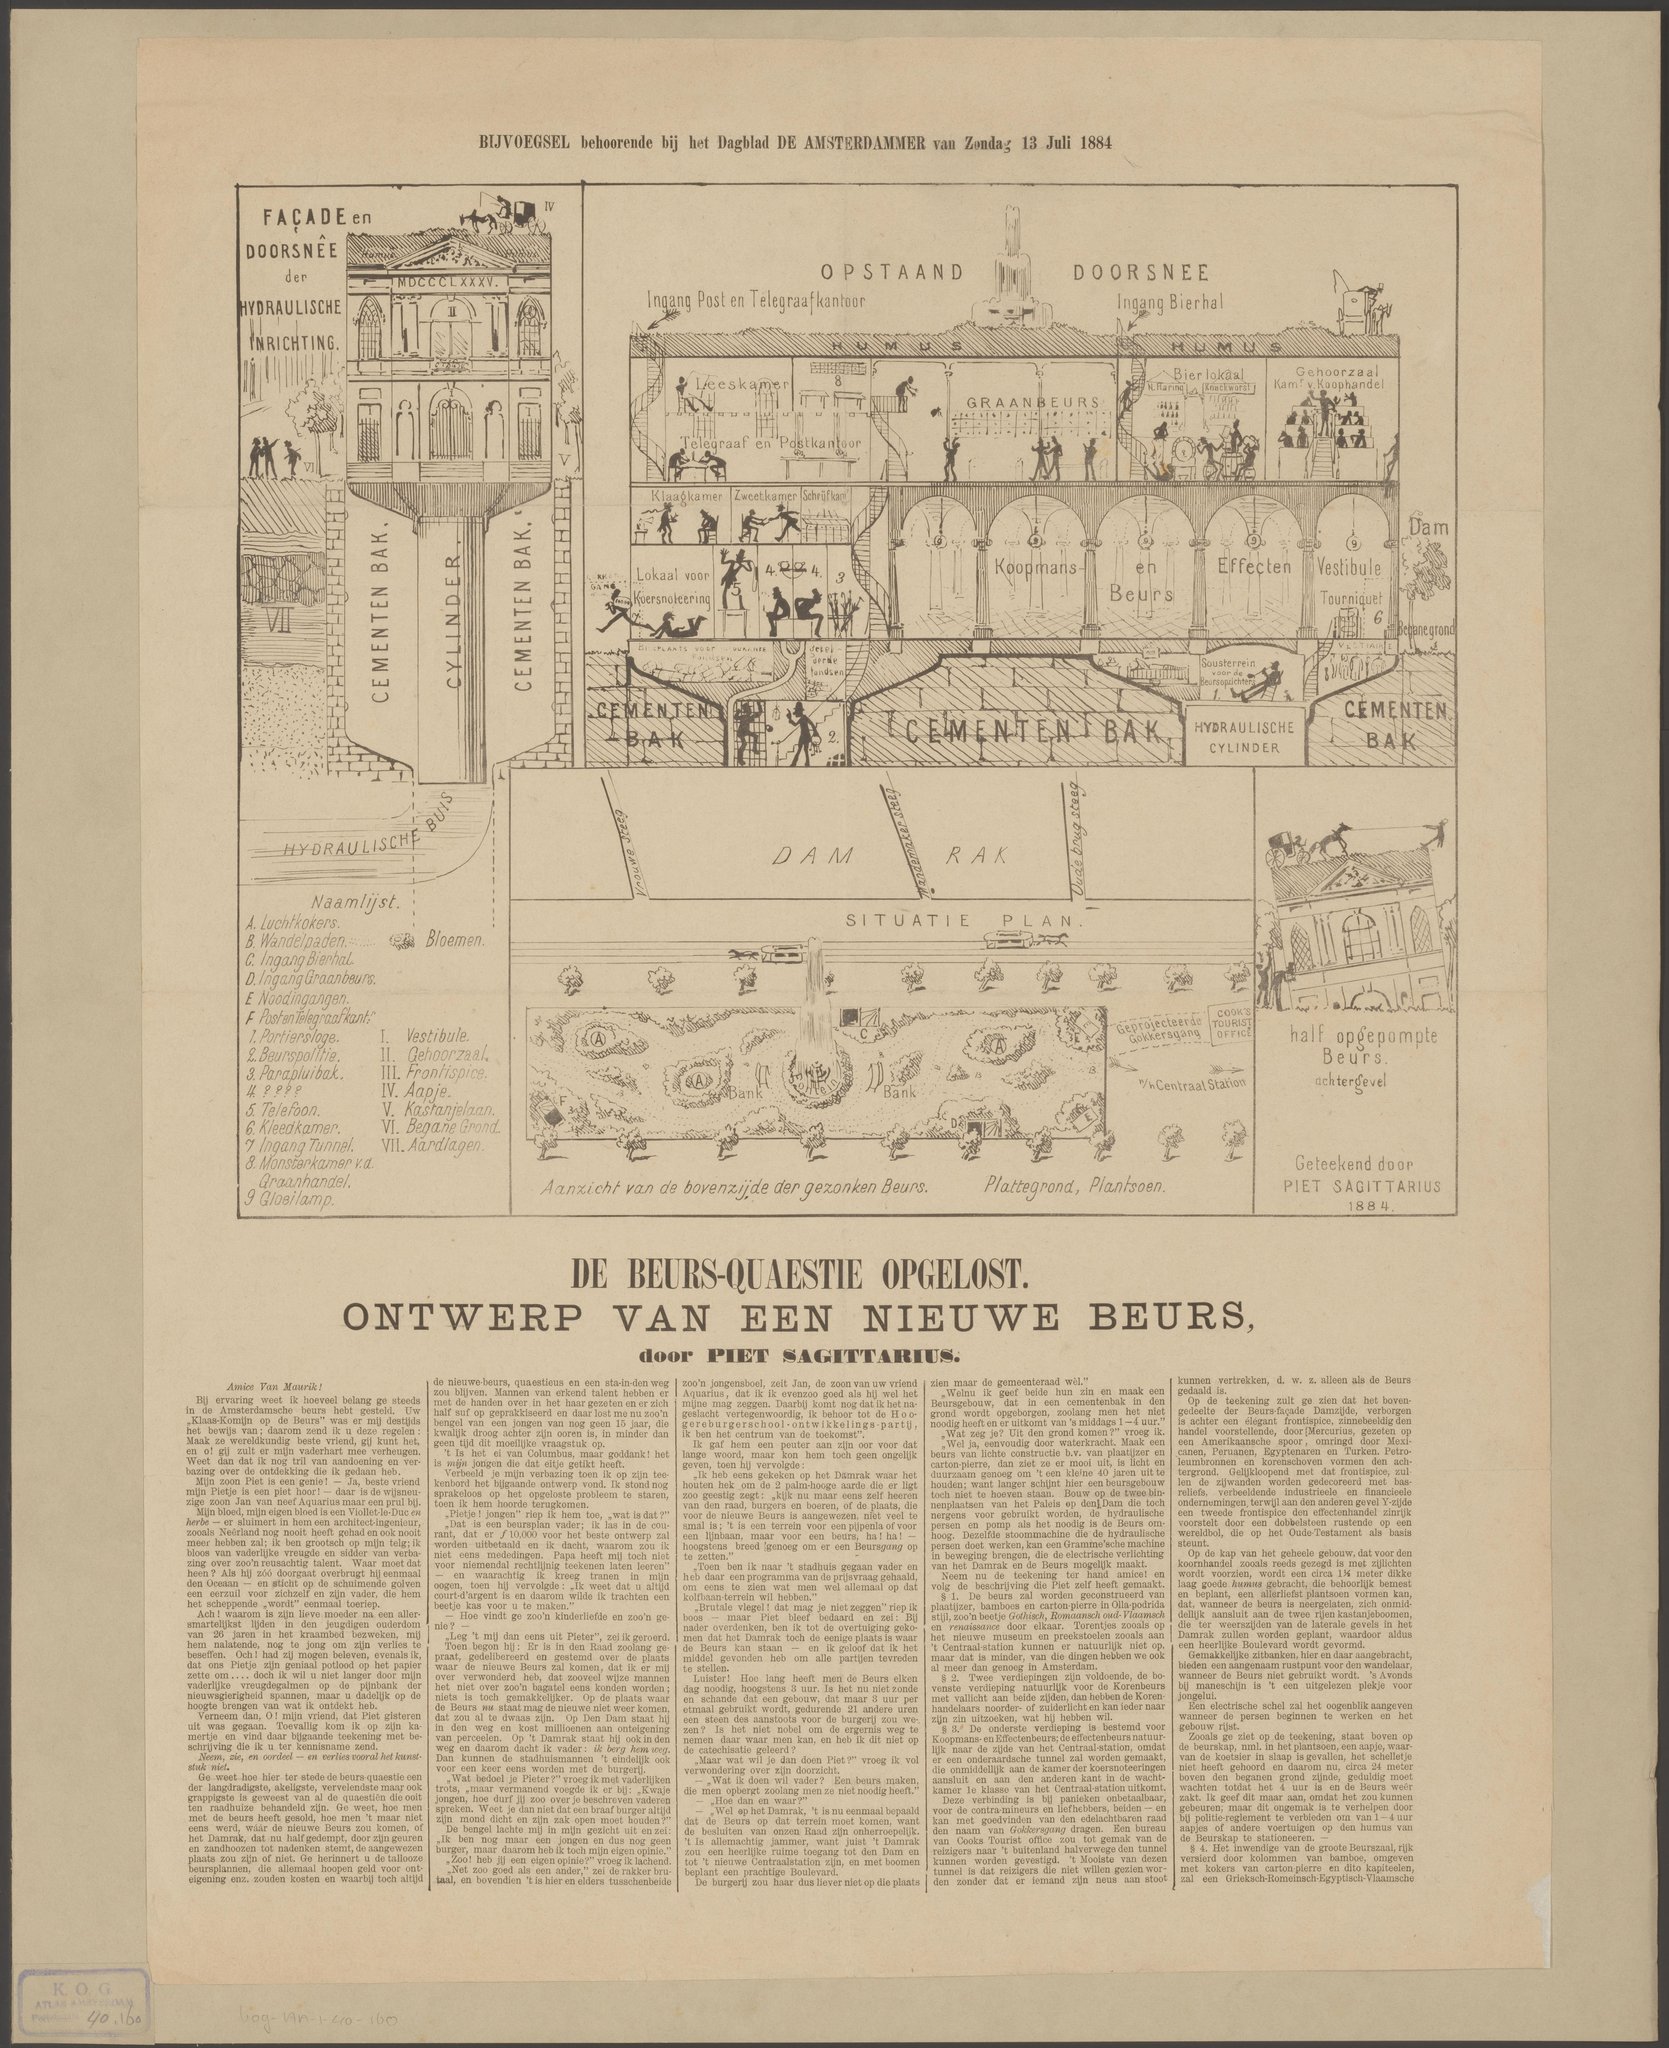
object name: print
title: Oplossing van de beurskwestie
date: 1884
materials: paper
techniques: letterpress printing, lithograph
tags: stock exchange, stock-market, amsterdam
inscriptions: collector's mark: Lugt 1641b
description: Oplossing van de beurskwestie, door Piet Sagittarius. Onderwerpsrubriek binnen de Atlas Amsterdam: Handel en Zeevaart, E. Spotprenten betreffende de Beurs.